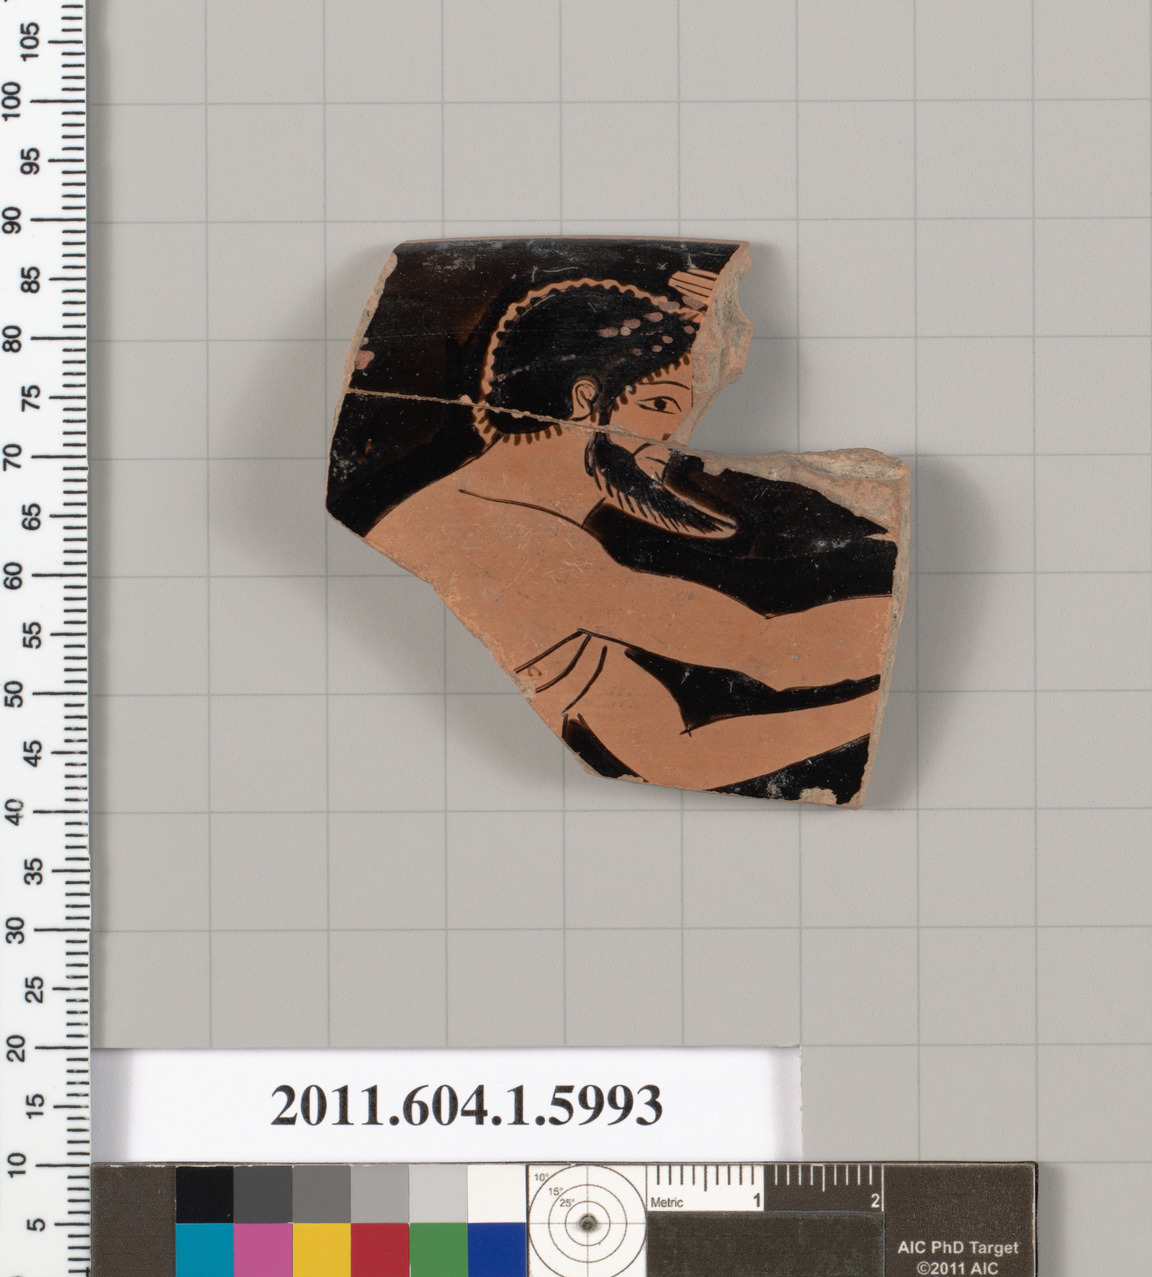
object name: kylix fragment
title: Terracotta rim fragment of a kylix (drinking cup)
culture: greek, attic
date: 510-500 BCE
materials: terracotta